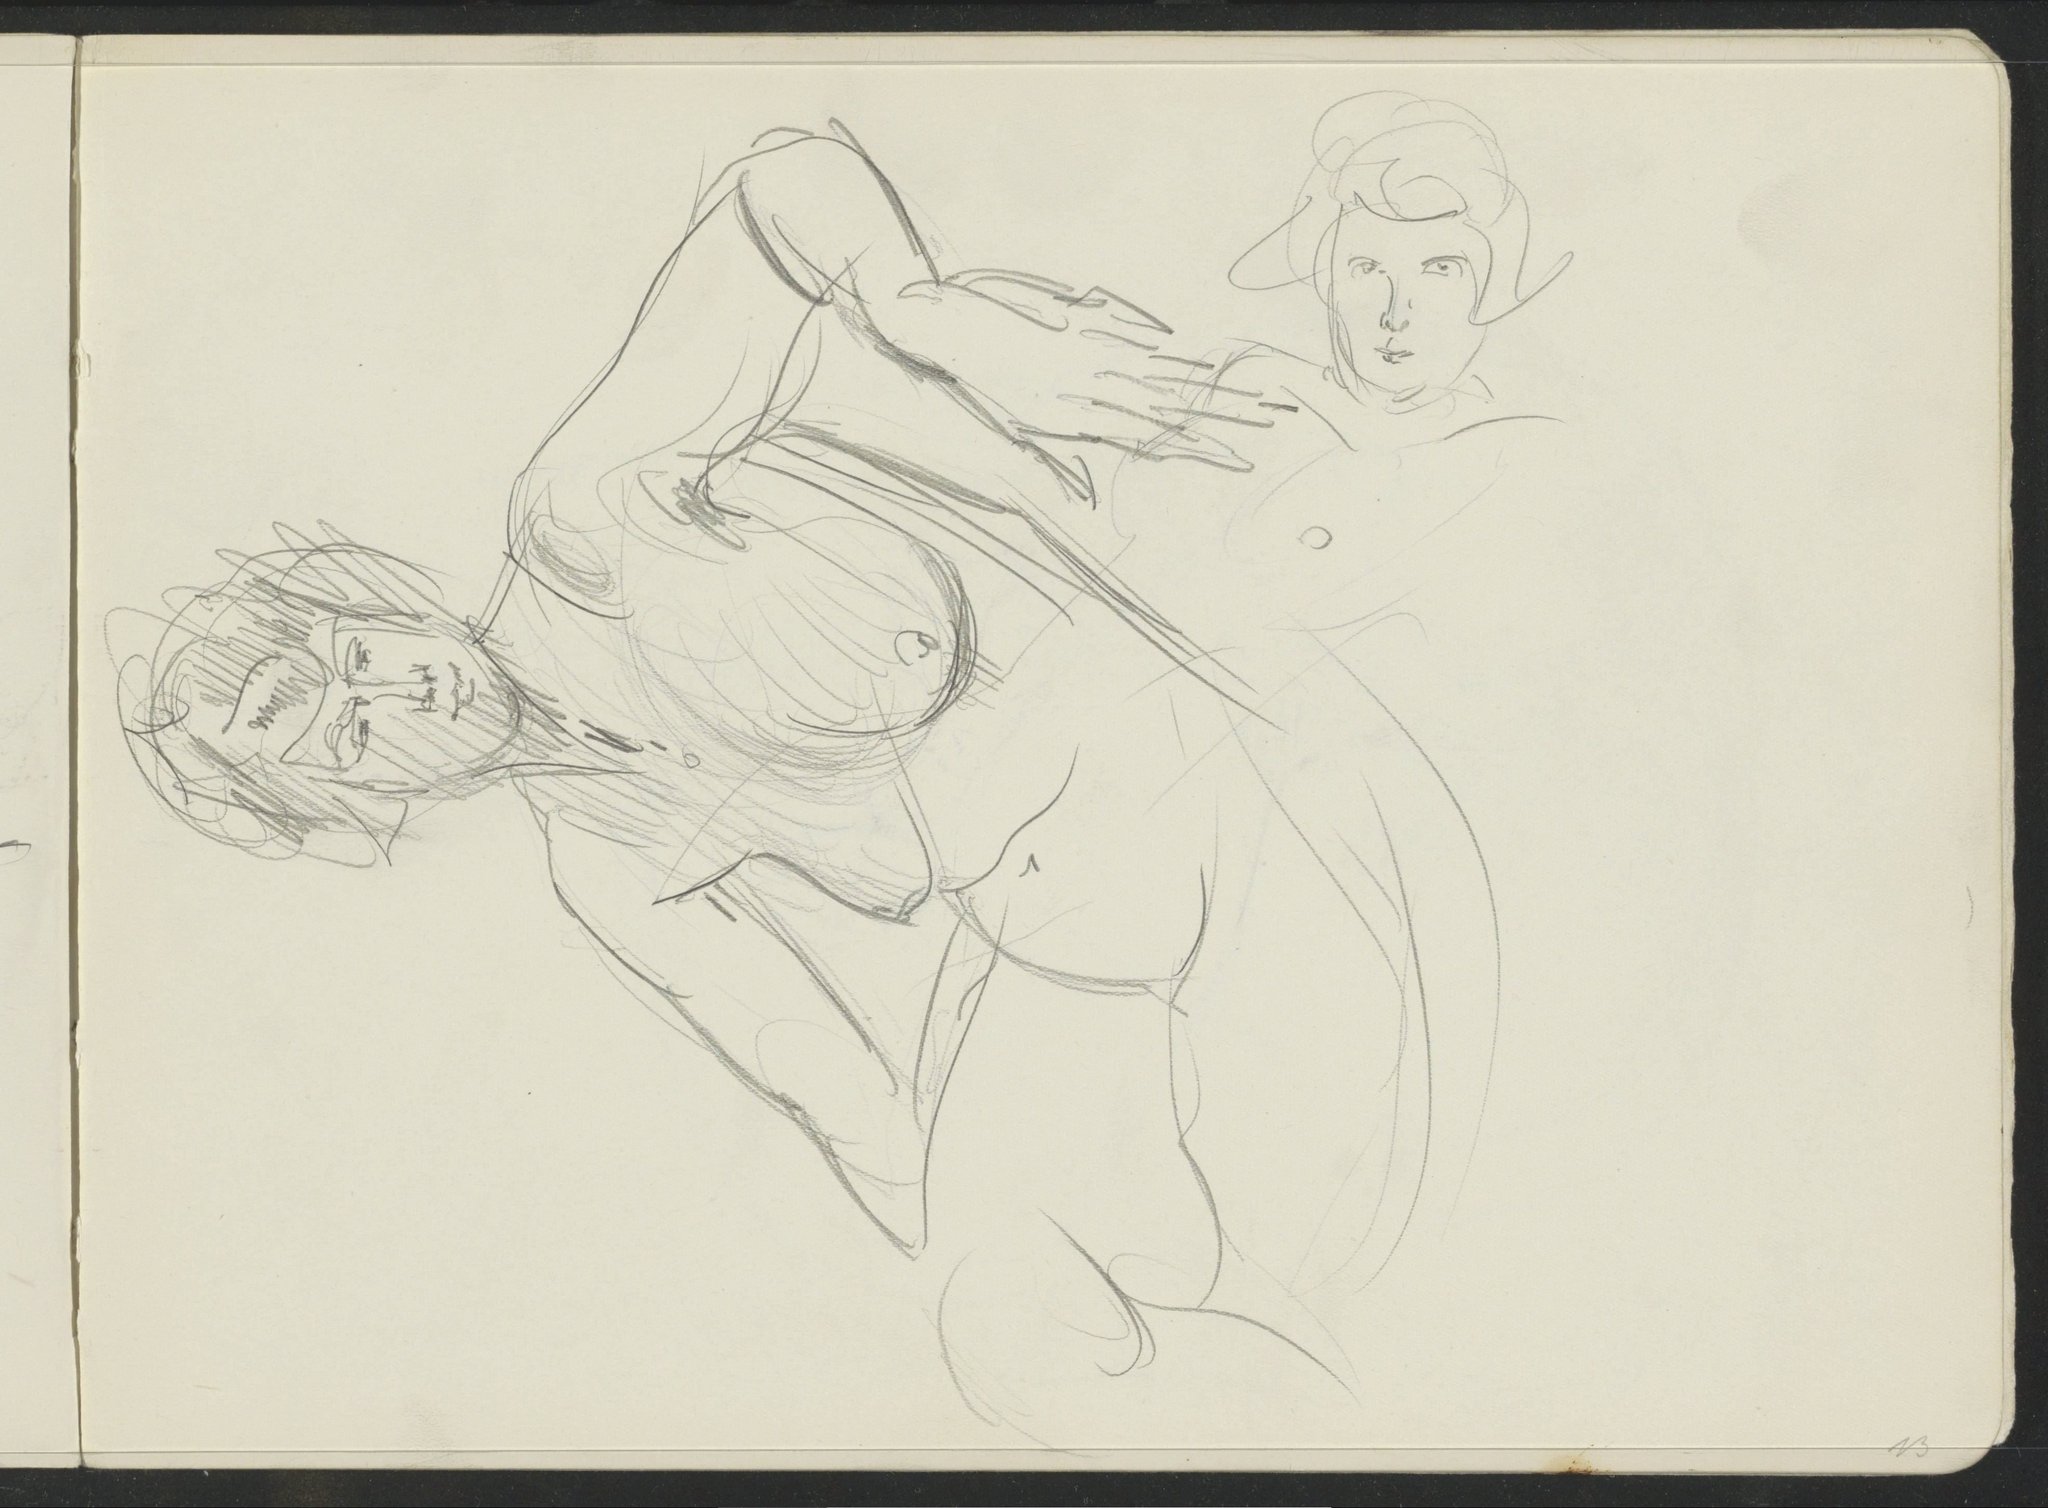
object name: sketchbook leaf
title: Seated Female Nude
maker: isaac israels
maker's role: draughtsman, painter, print maker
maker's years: 1865-1934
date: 1915-1934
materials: paper, pencil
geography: the hague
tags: sitting figure - aa - female human figure, head (human) - aa - female human figure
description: Haar linkerarm rust mogelijk op een leuning. Ernaast een vrouwenhoofd. Blad 13 recto uit schetsboek XV met 22 bladen.